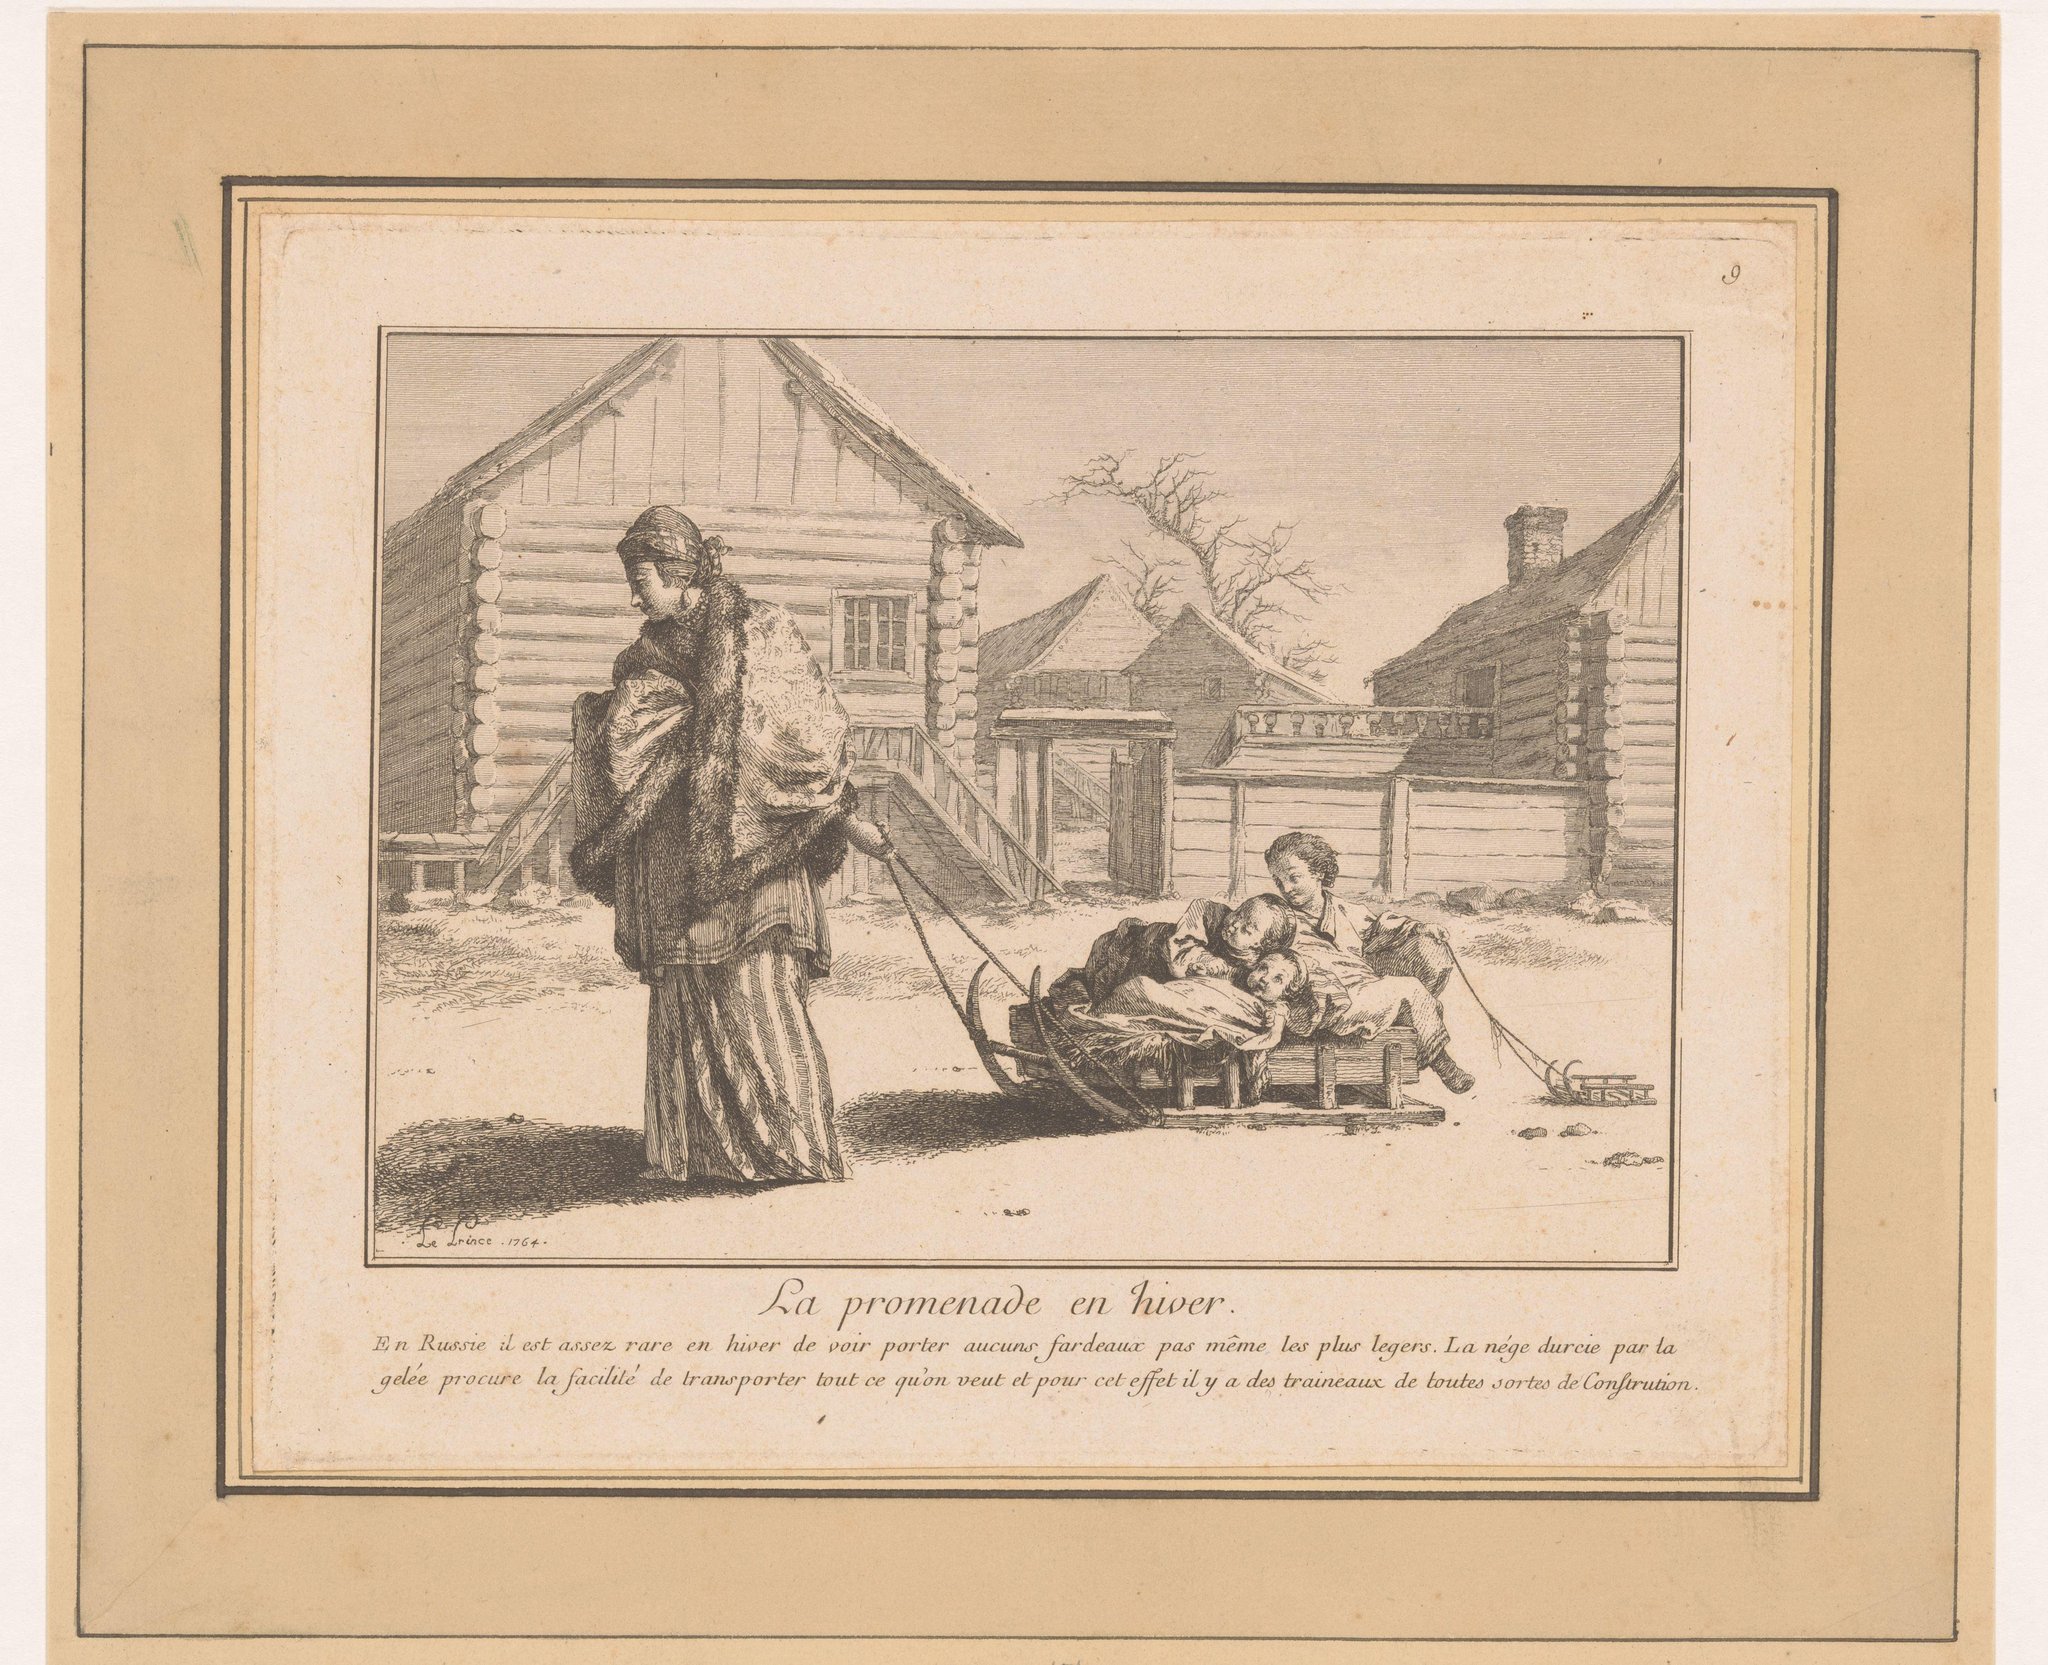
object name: print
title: La promenade en hiver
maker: jean baptist leprince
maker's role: draughtsman, print maker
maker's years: 1734-1781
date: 1764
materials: paper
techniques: etching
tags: sledge, sleigh (winter sports)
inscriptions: date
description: Maakt deel uit van een tiendelige serie met Russische tradities en gebruiken.